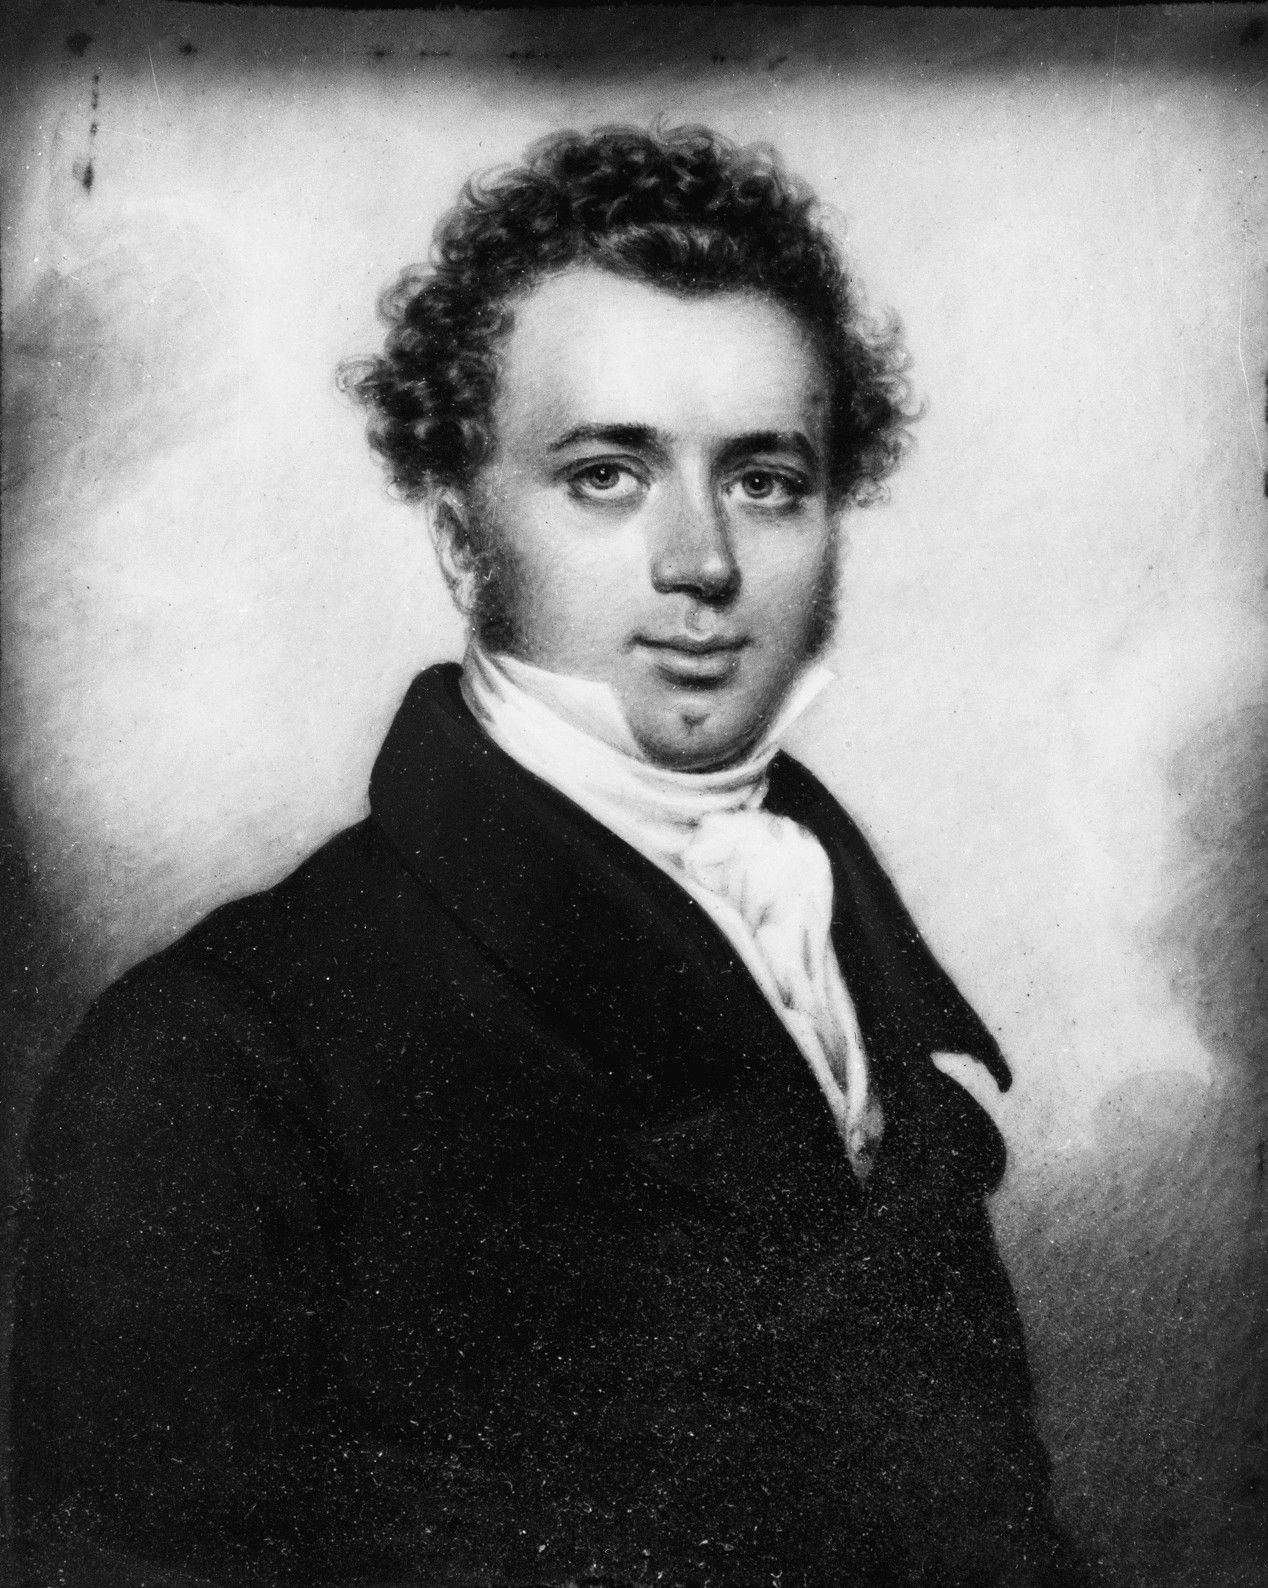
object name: painting, miniature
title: Jean Pierre Barre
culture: american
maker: nathaniel rogers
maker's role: artist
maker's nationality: american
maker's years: 1788-1844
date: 1820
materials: ivory, watercolor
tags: men,portraits